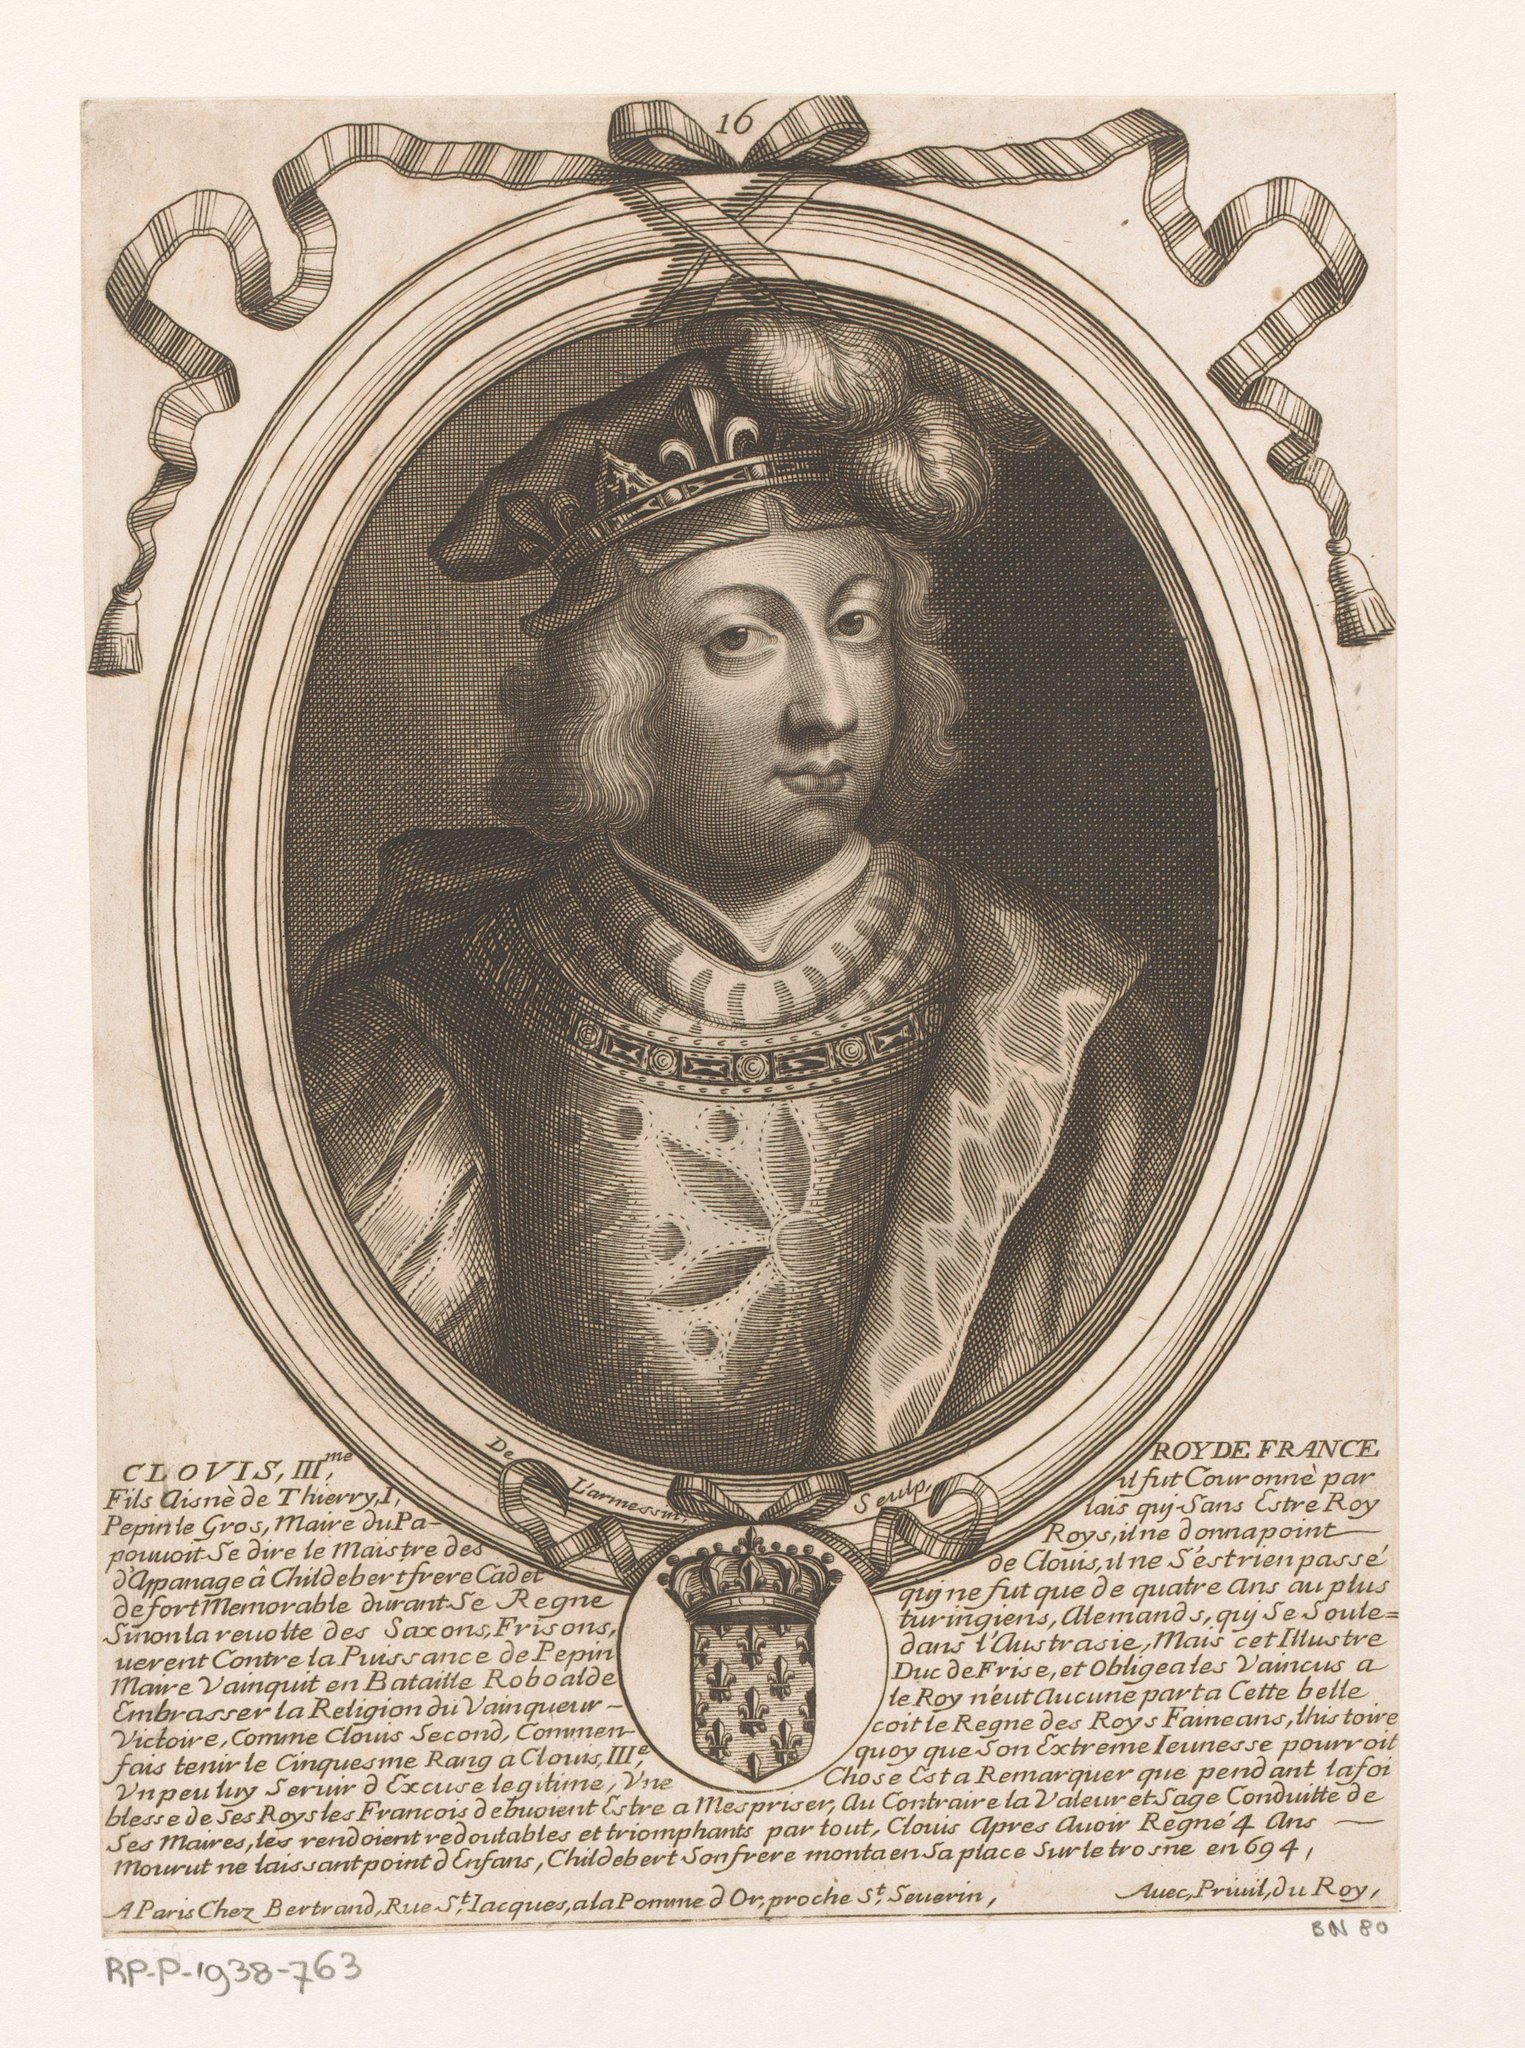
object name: print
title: Portretten van prominente figuren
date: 1647-1678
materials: paper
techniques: engraving, etching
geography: france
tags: historical persons, king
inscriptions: collector's mark: Lugt 2228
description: Maakt deel uit van een grootschalige serie met portretten van prominente figuren. Binnen de serie bevindt zich een sectie getiteld 'Les Augustes Représentations De tous les Roys De France depuis Pharamond Iusqu'à Louys XIIII'. De serie werd respectievelijk uitgegeven door Pierre Bertrand, door zijn weduwe en door De Larmessin zelf.